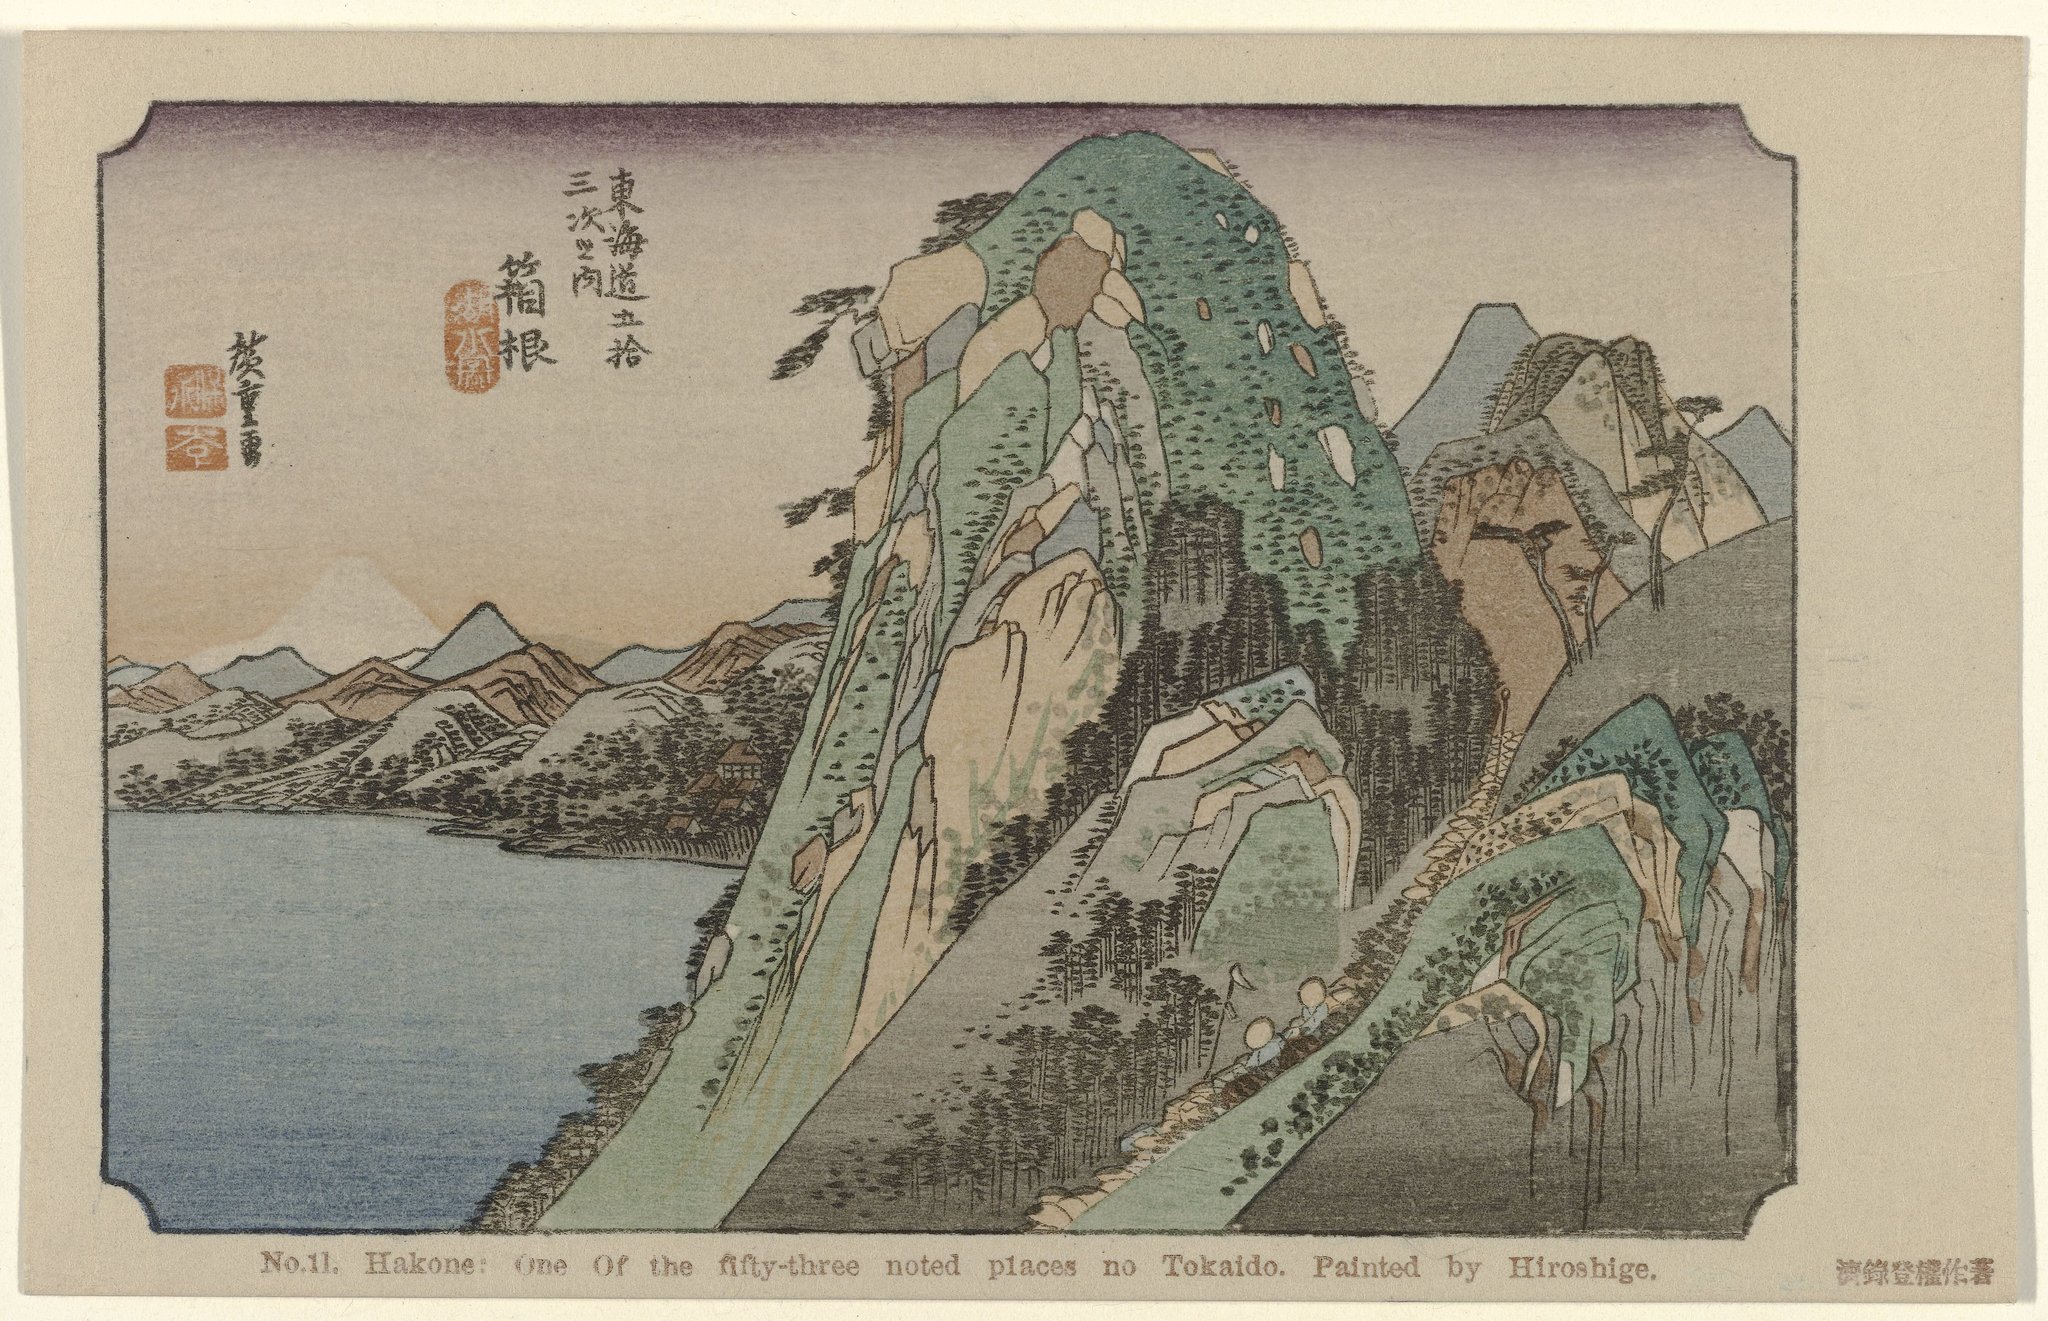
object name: ansichtkaart, prentbriefkaart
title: De Tôkaidô van Hiroshige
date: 1906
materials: cardboard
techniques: woodcut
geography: japan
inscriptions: date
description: Een lange processie voor een krijgsheer (daimyo) beklimt de stijle weg tussen het gebergte, het Hakone meer rechts met de berg Fuji in de verte.